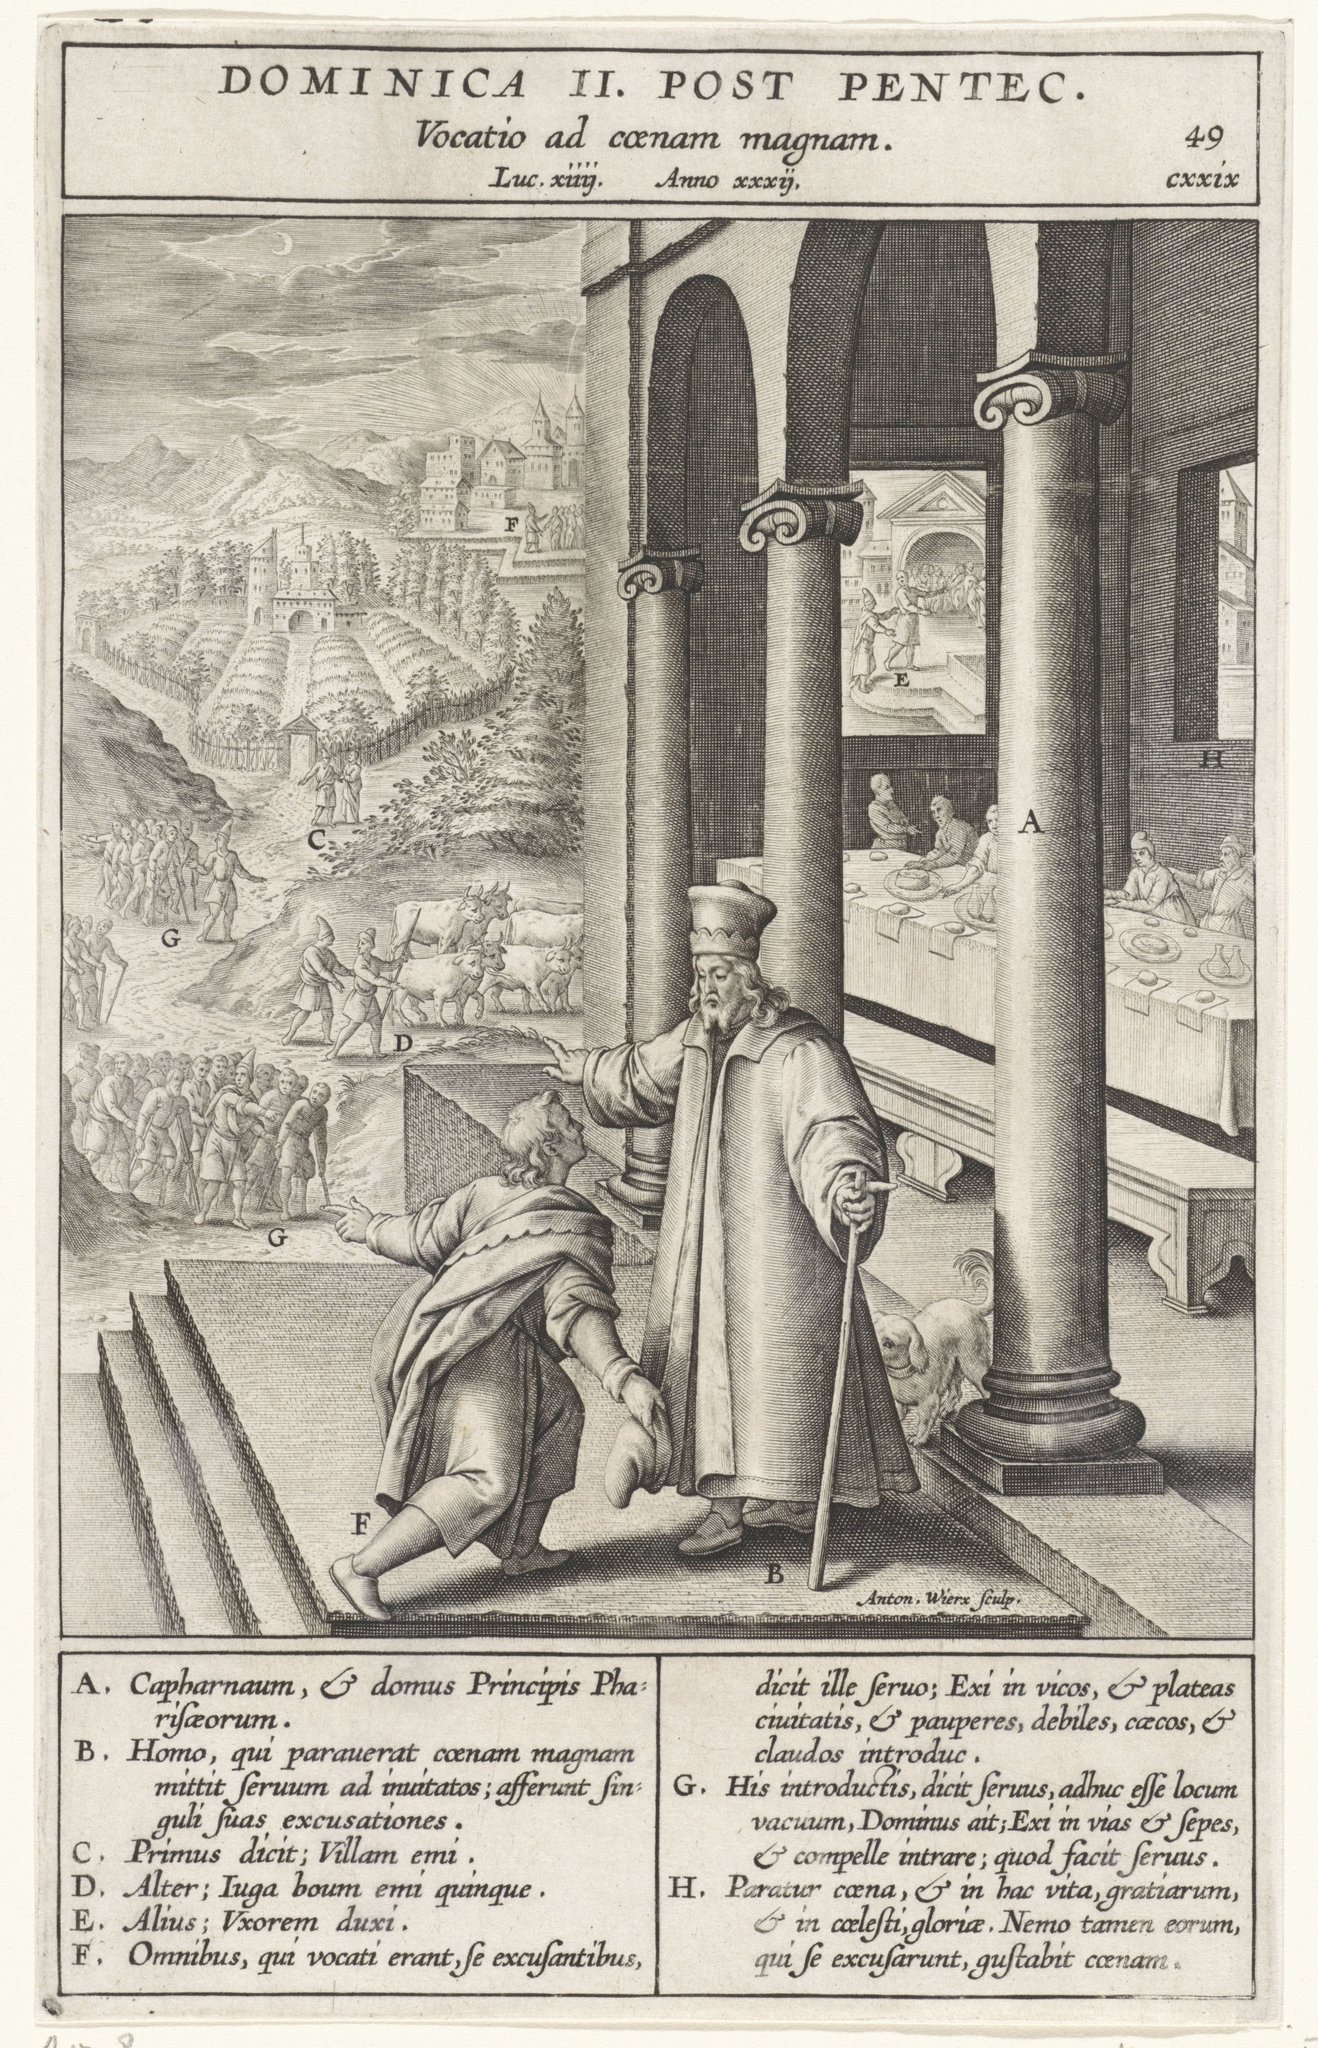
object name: print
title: De koning laat zijn dienaren gasten uitnodigen voor het bruiloftsfeest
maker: antonie wierix (ii)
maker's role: draughtsman, print maker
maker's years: 1555-1604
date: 1593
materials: paper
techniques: engraving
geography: antwerp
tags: first invitation to the feast ~ parable of the royal wedding-feast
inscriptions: collector's mark: Lugt 2165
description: De koning geeft een bruiloftsfeest voor zijn zoon. Hij stuurt zijn dienaren eropuit om de bruiloftsgasten uit te nodigen, maar die willen niet komen. Bij verschillende elementen uit de voorstelling staan letters die corresponderen met de legenda in de marge.